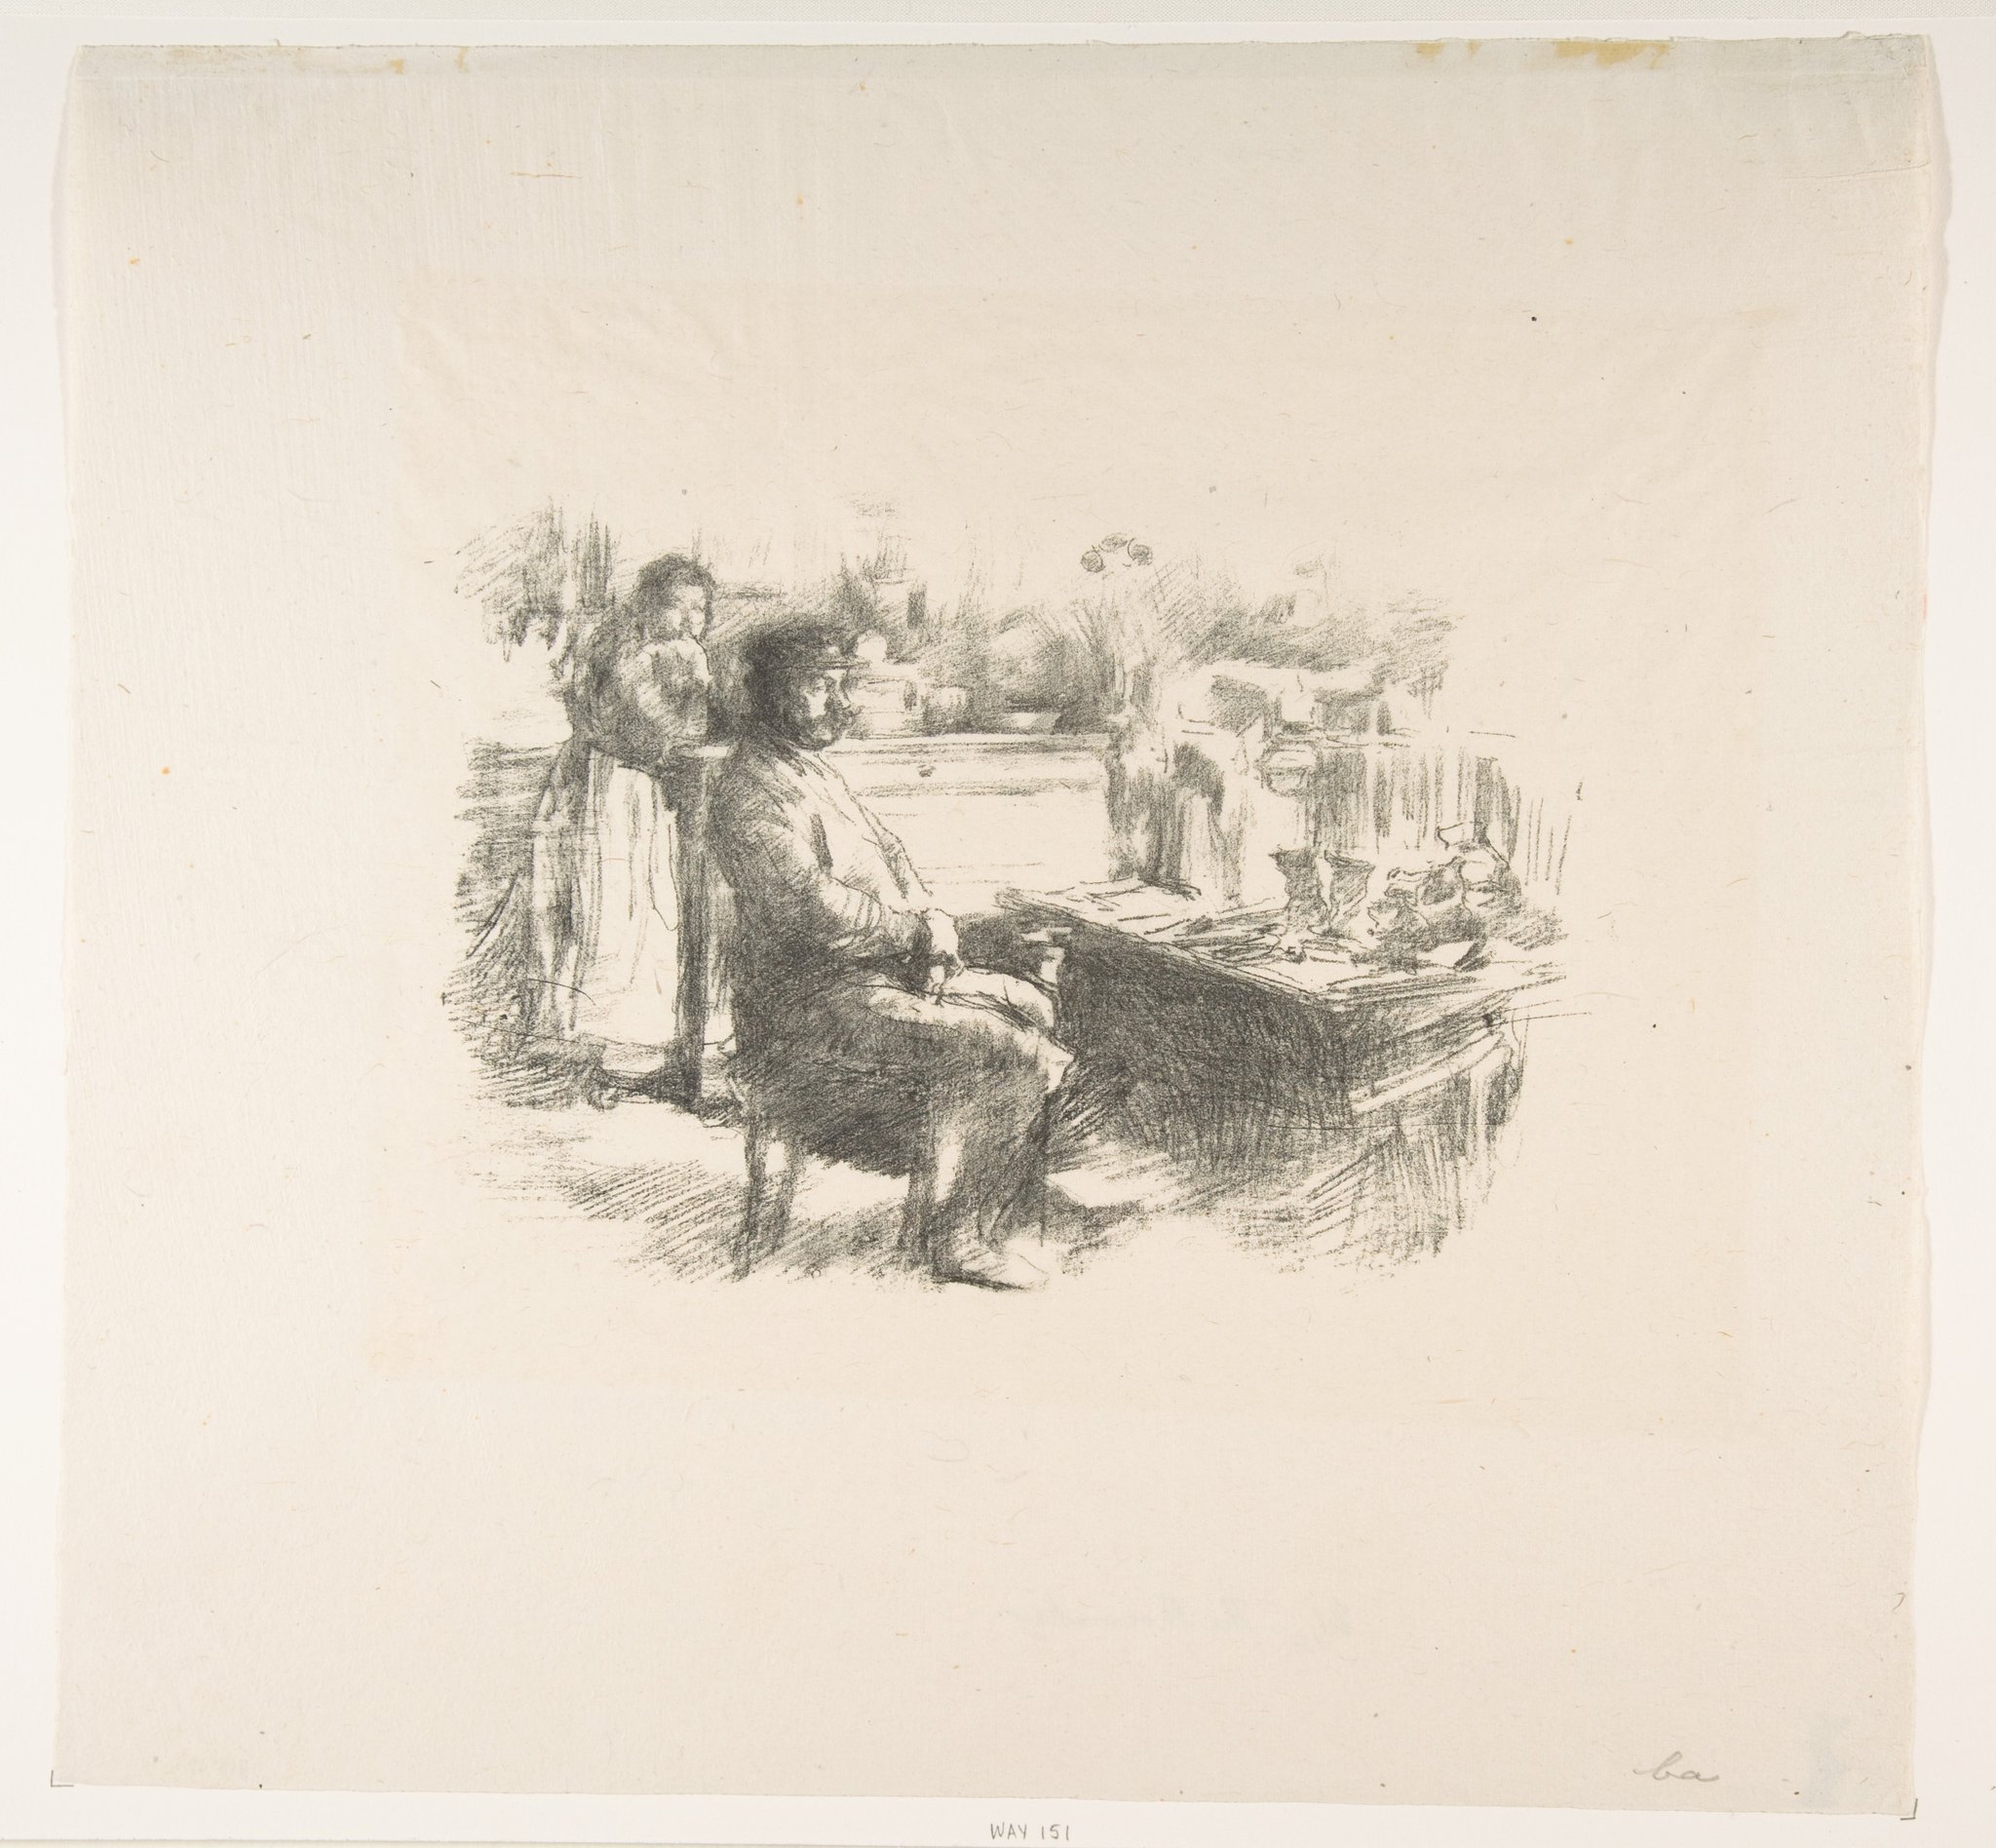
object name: print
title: The Shoemaker (The Shoemaker, Dieppe)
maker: james mcneill whistler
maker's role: artist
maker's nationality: american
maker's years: 1834-1903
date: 1896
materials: paper, ink, ivory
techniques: printing, stumping, lithography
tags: men,women